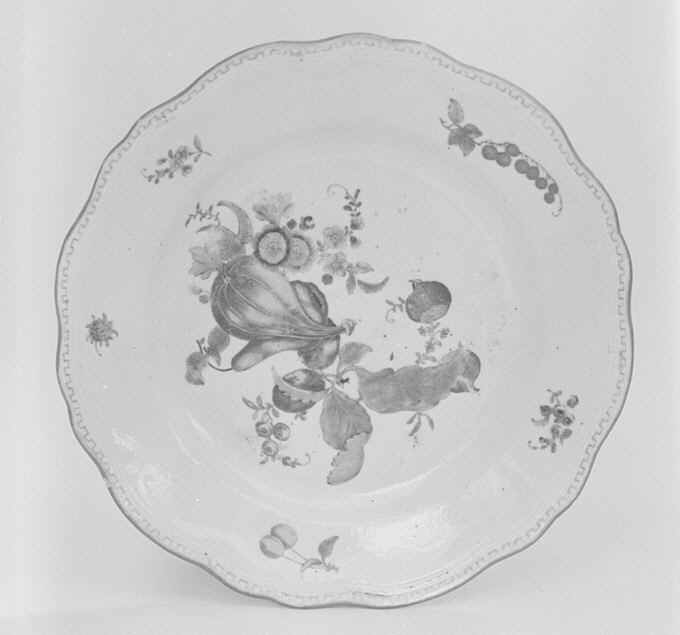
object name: dinner plate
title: Dinner plate (part of a service)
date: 1760-1770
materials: hard paste porcelain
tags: flowers